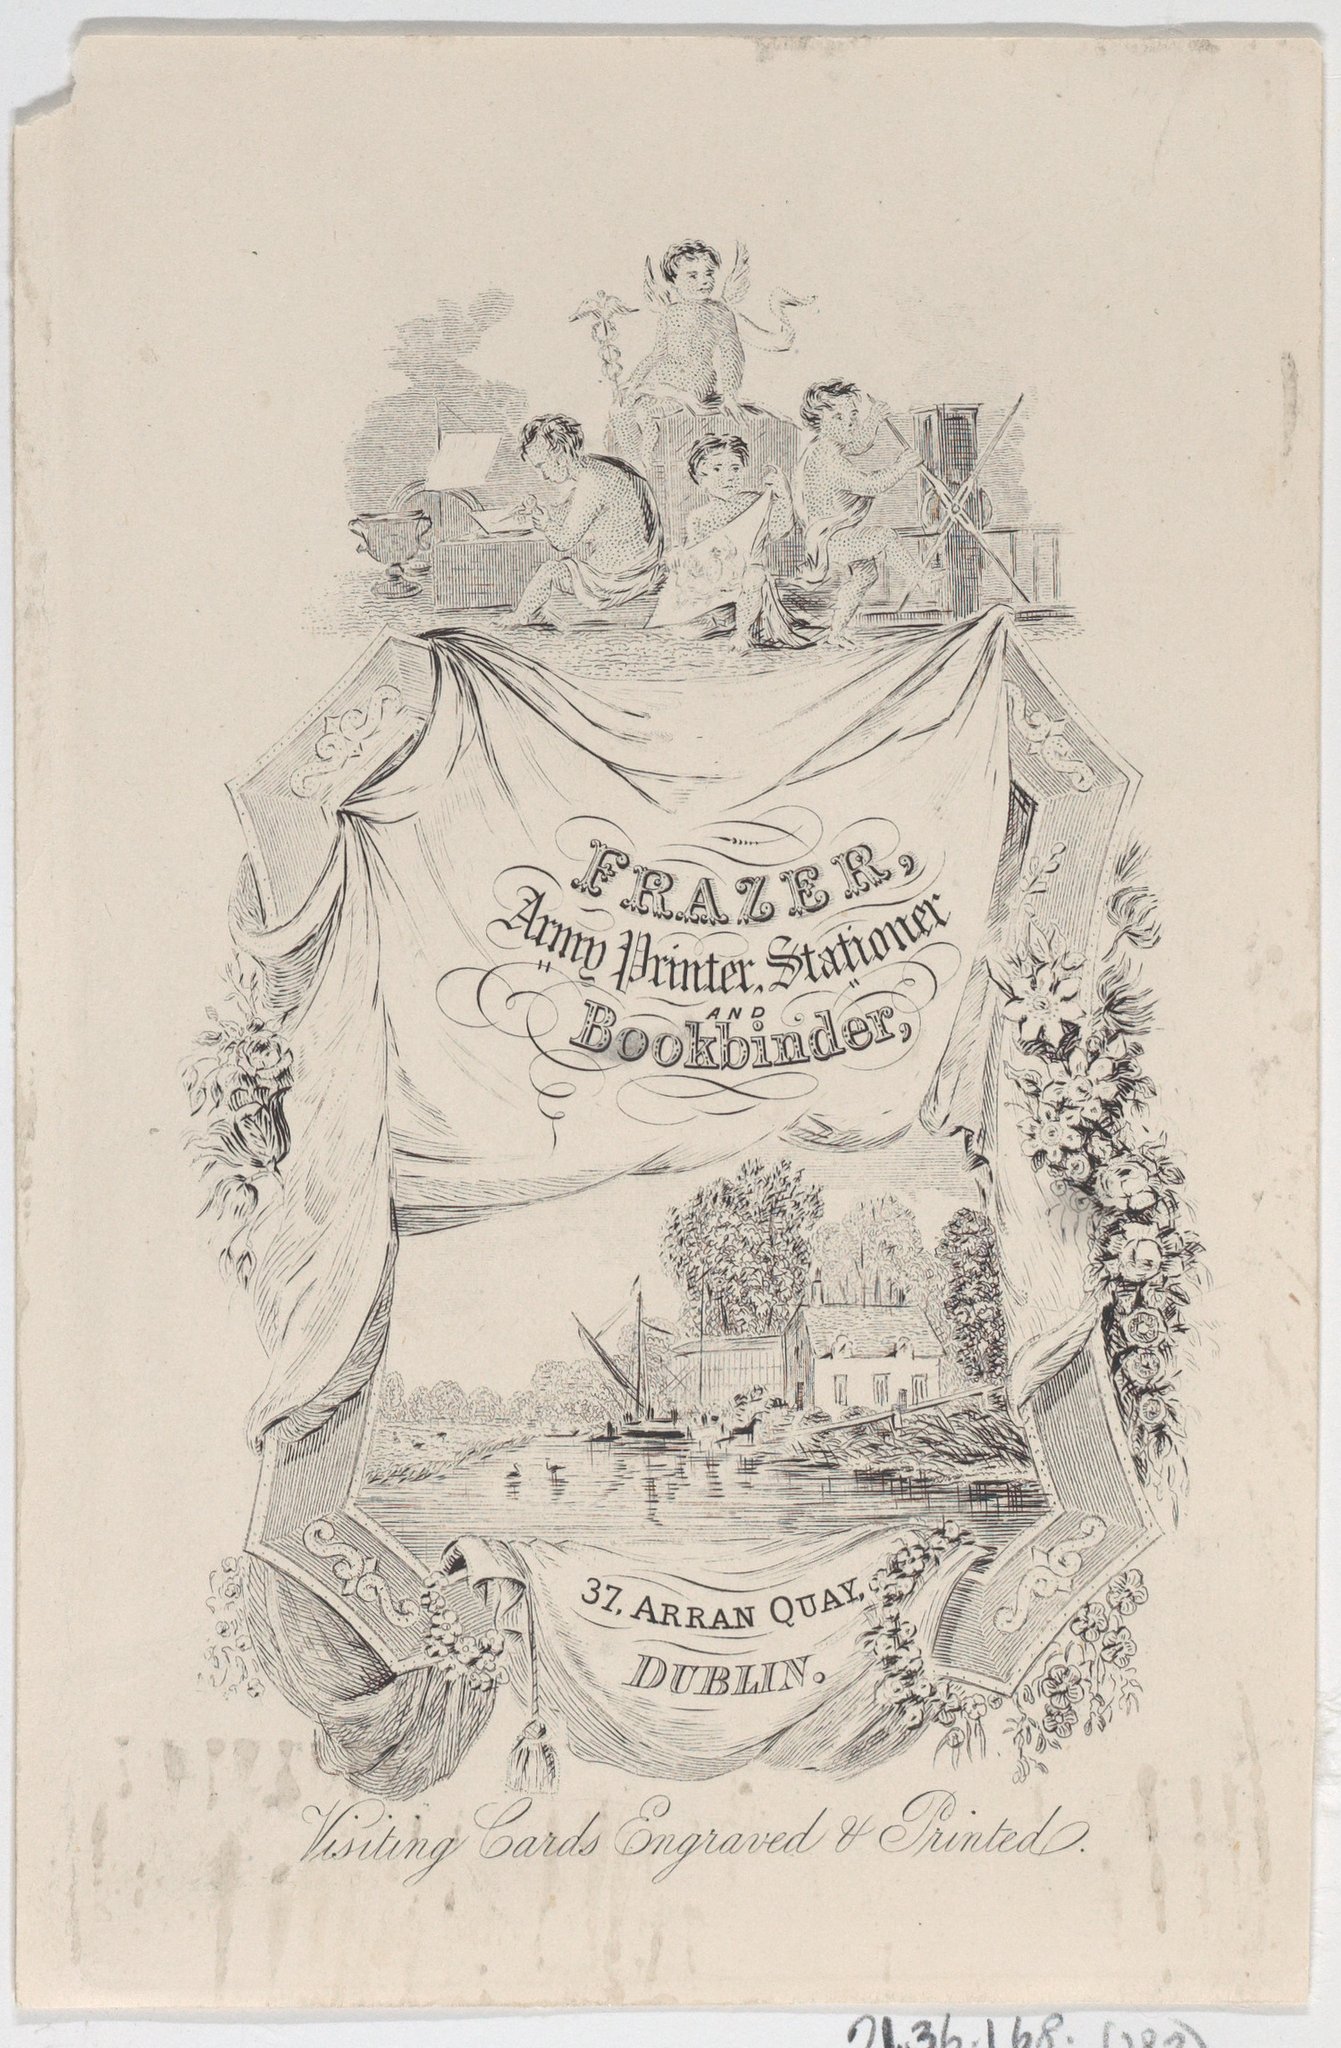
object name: print, trade card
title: Trade card for Frazer, Army Printer, Stationer and Bookbinder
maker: anonymous, irish, 19th century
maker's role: artist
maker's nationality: irish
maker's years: 1800-1900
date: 1801-1900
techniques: engraving